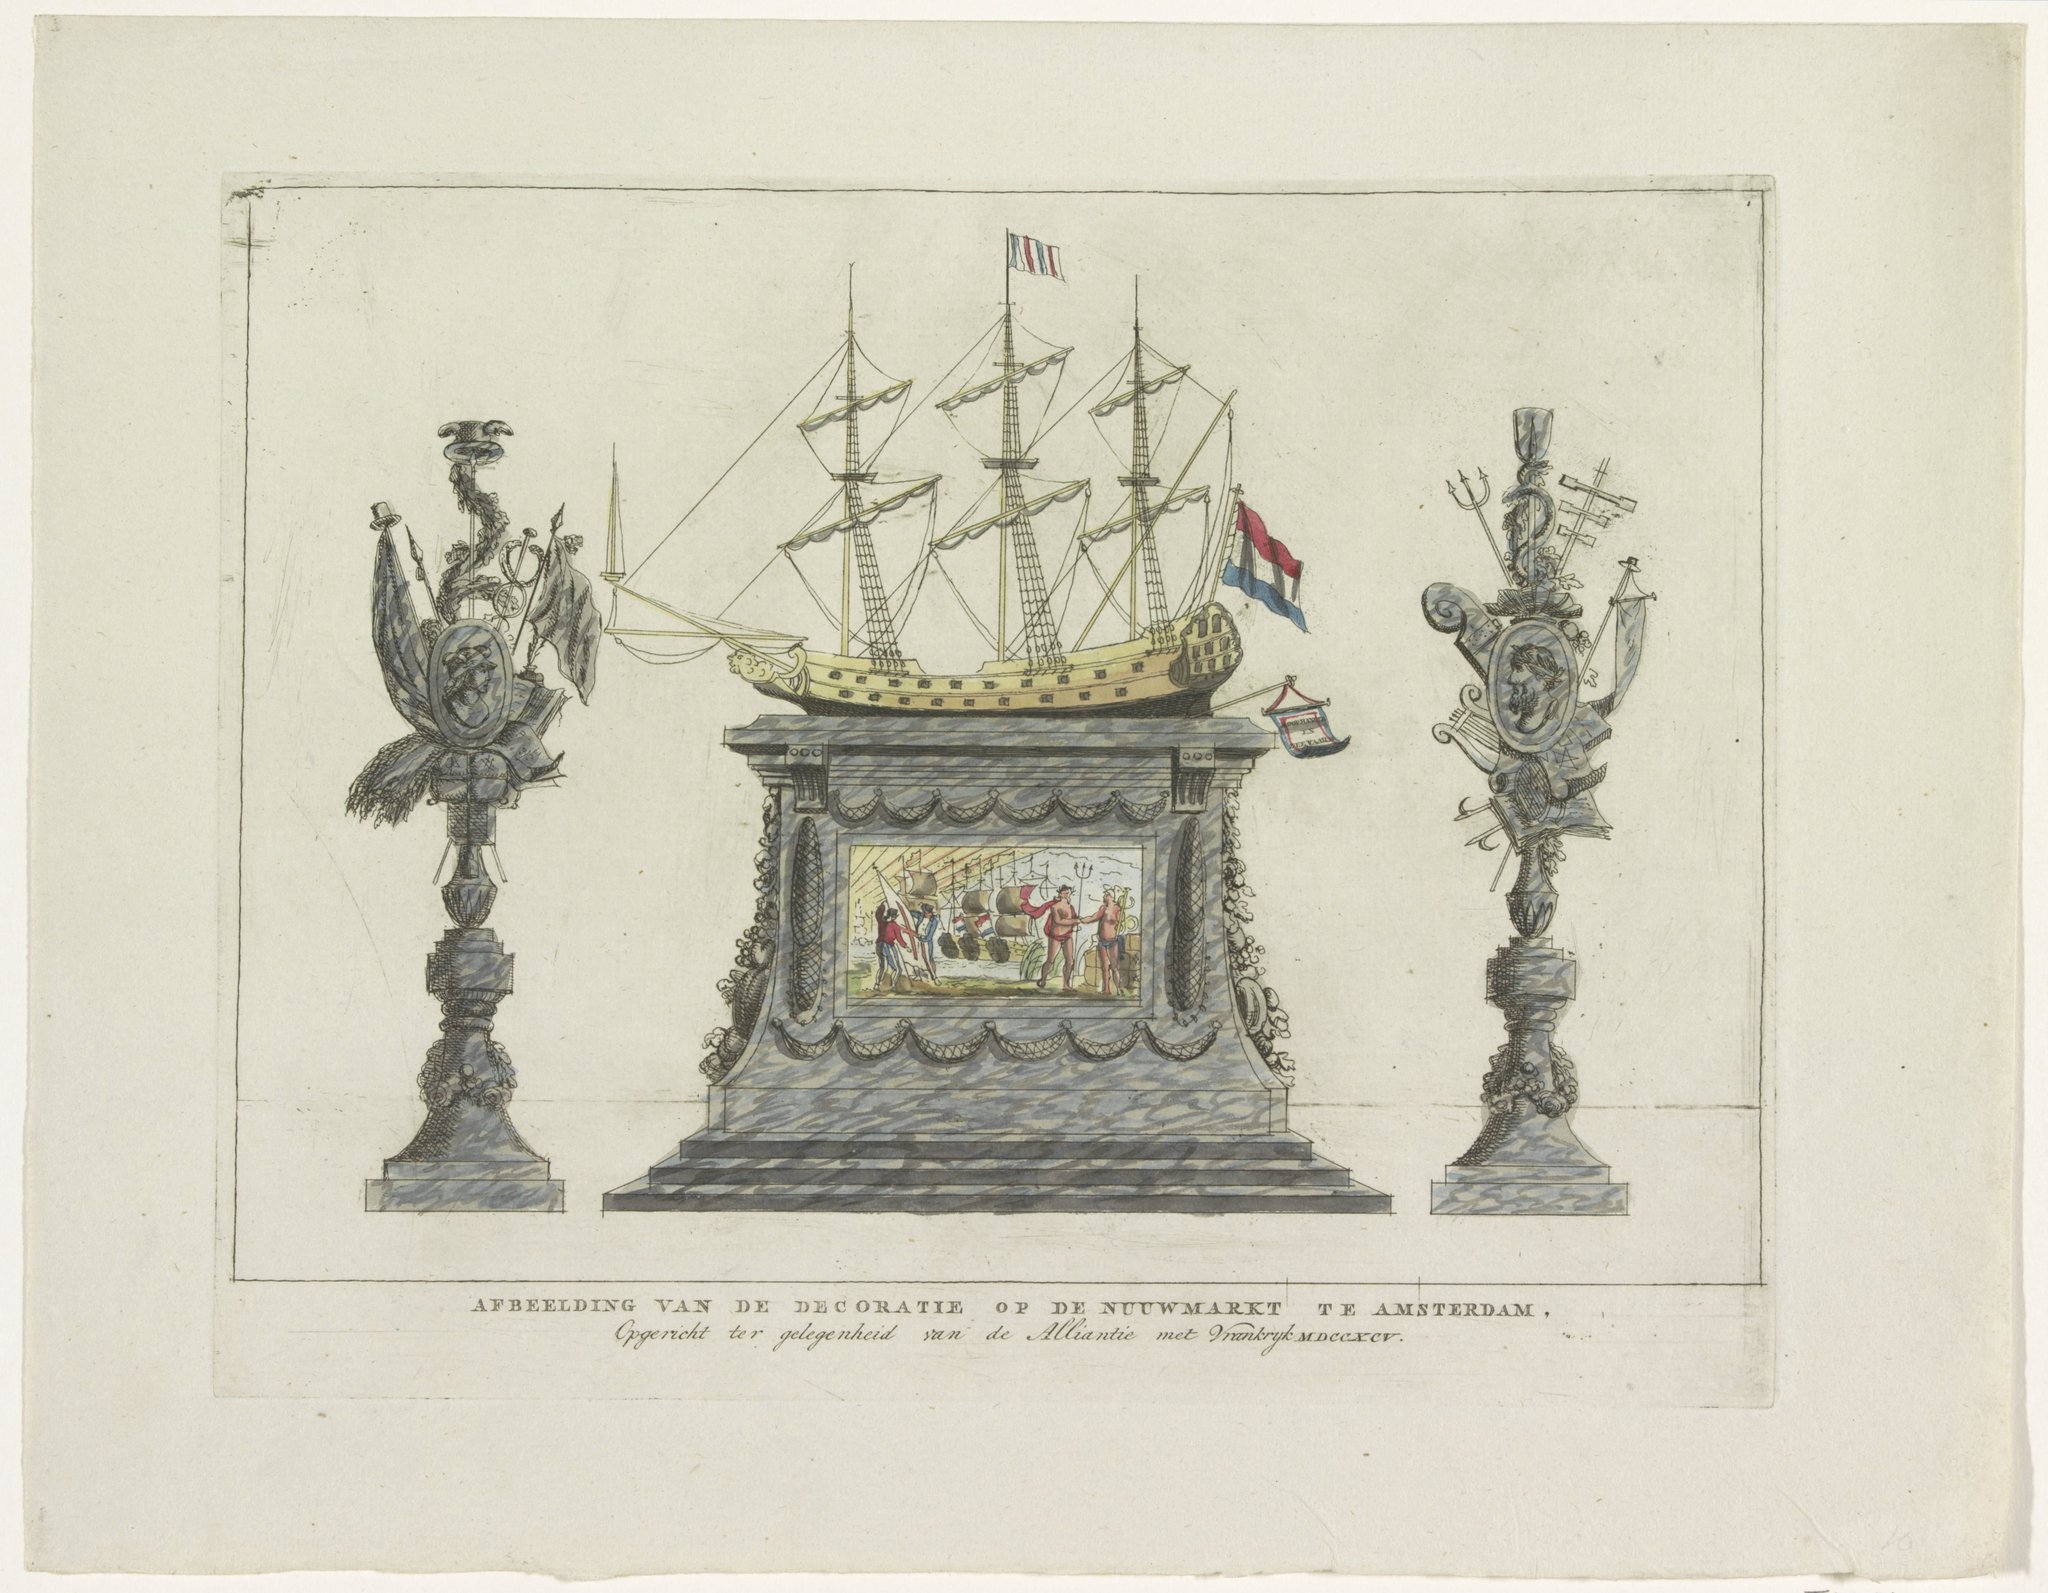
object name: print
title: Afbeelding van de Decoratie op de Nuuwmarkt te Amsterdam. Opgericht ter gelegenheid van de Alliantie met Vrankryk MDCCXCV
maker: Anonymous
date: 1795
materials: paper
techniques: etching, hand coloring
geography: netherlands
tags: ship-model (+ propulsion of vehicle, ship, etc. by wind), festivities on events of national importance (+ festive decoration ~ festive activities), amsterdam, alliance with france (1795)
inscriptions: collector's mark: Lugt 2228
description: Koophandel en Zeevaart, allegorische decoratie opgericht in de Nieuwmarkt te Amsterdam bij het Alliantiefeest op 19 juni 1795. Reusachtig model van een koopvaardijschip op een voetstuk met chassinet met voorstelling van Neptunus en Mercurius die elkaar de hand schudden terwijl de Franse en Bataafse matroos de Britse vlag aan stukken scheuren. Onderdeel van een serie van tien platen.